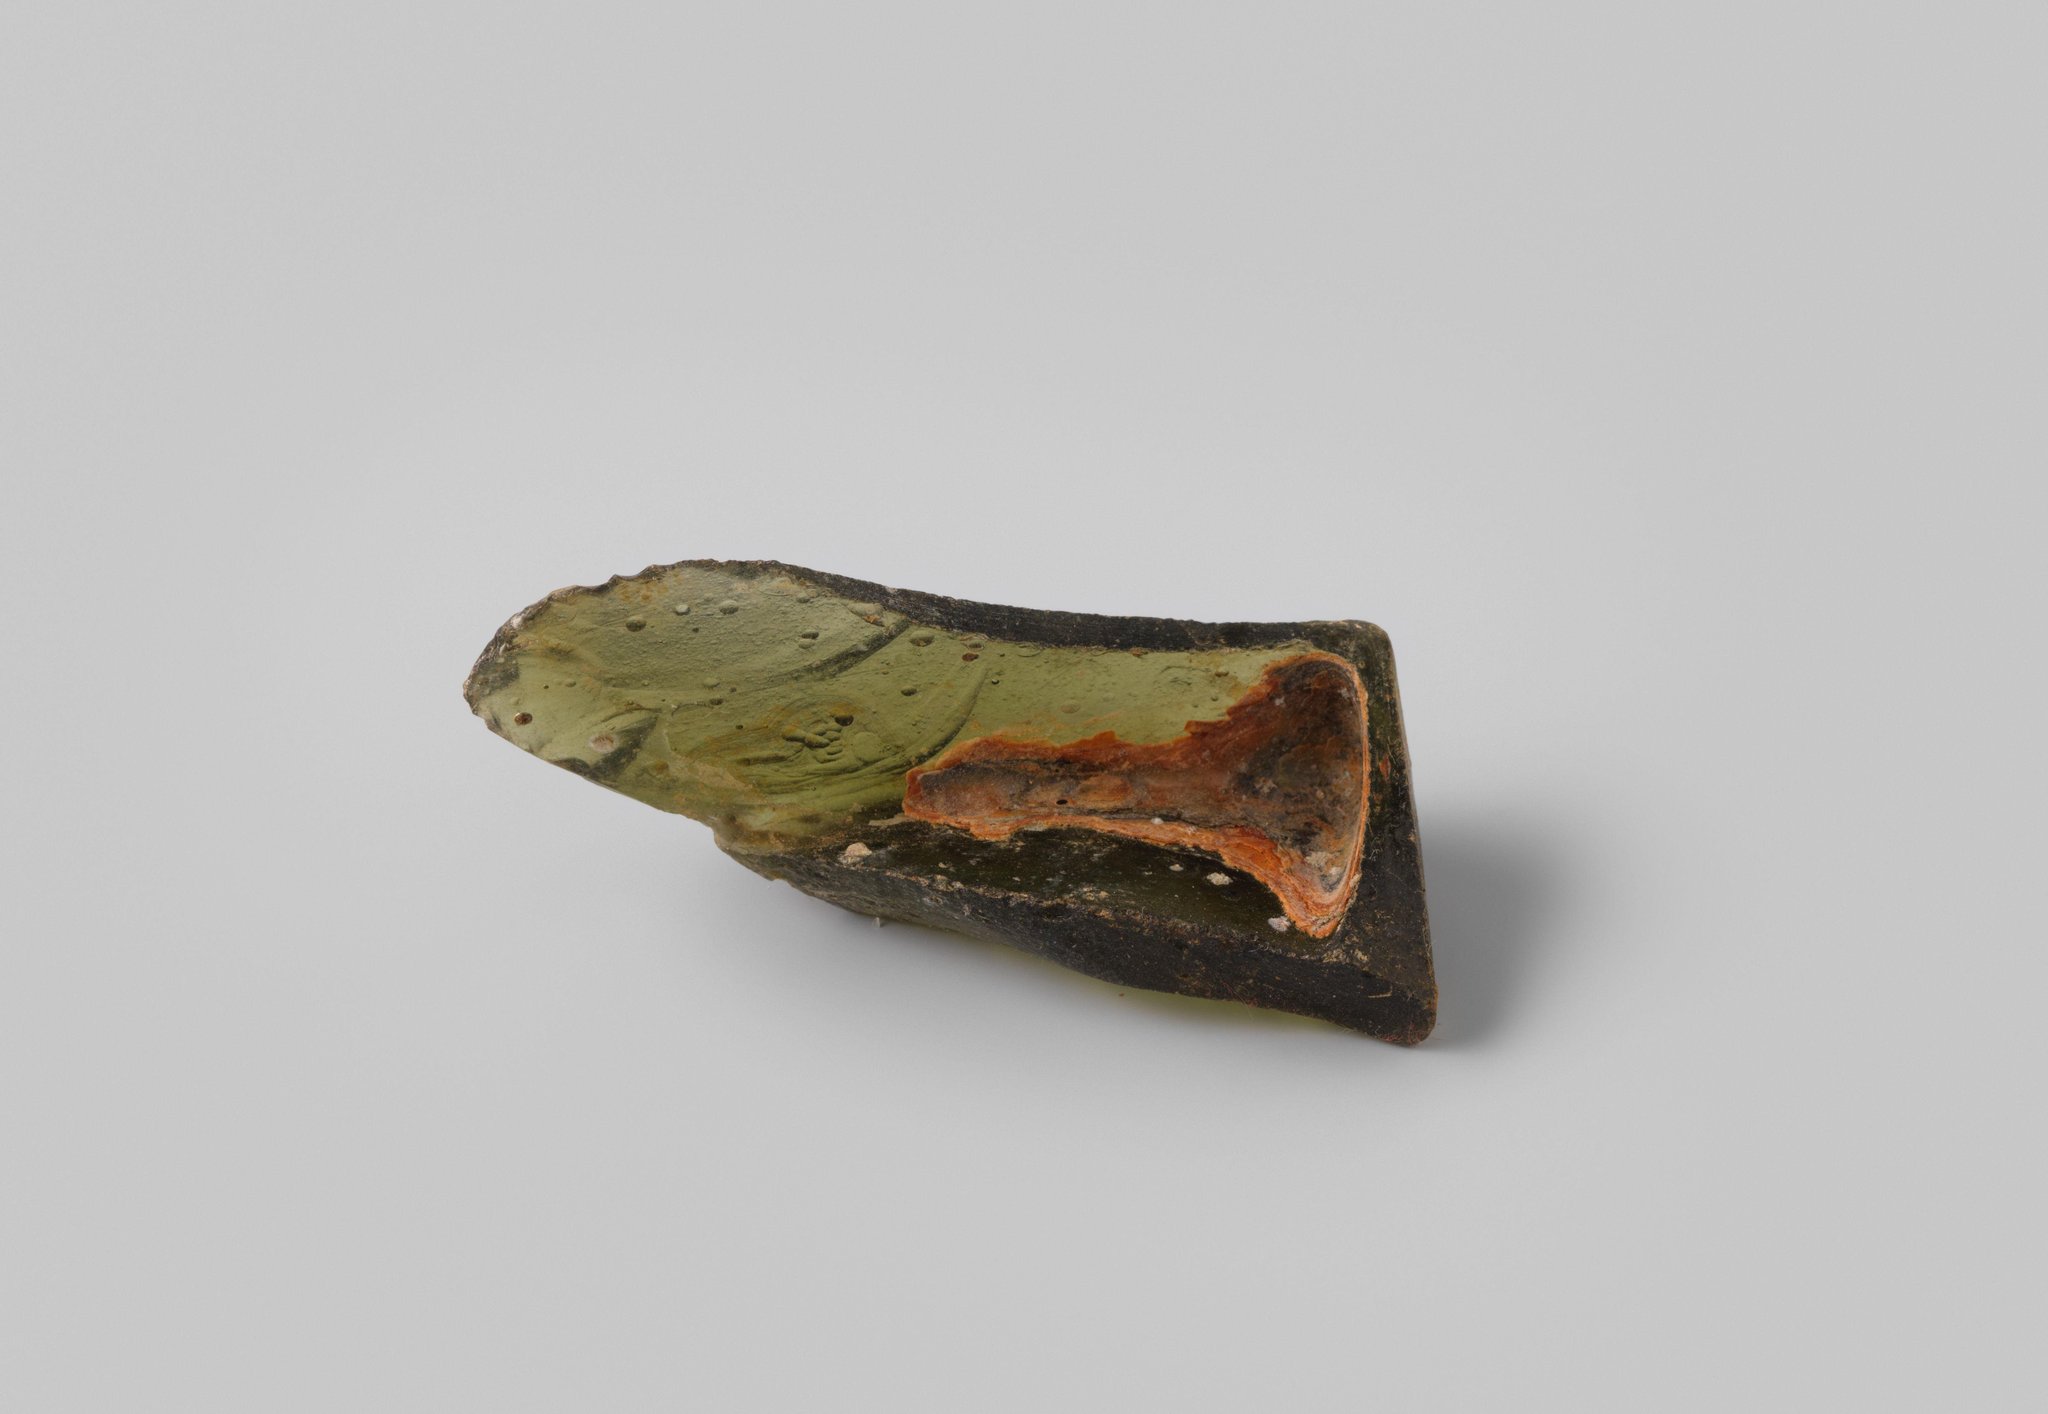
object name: case bottle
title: Fragment kelderfles uit het wrak van de Oost-Indiëvaarder Hollandia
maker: Anonymous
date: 1700-1743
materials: glass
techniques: green glass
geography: netherlands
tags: verenigde oostindische compagnie, hollandia (schip), annet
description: Case bottle, fragm of base, corner, sim. 80H1872b.